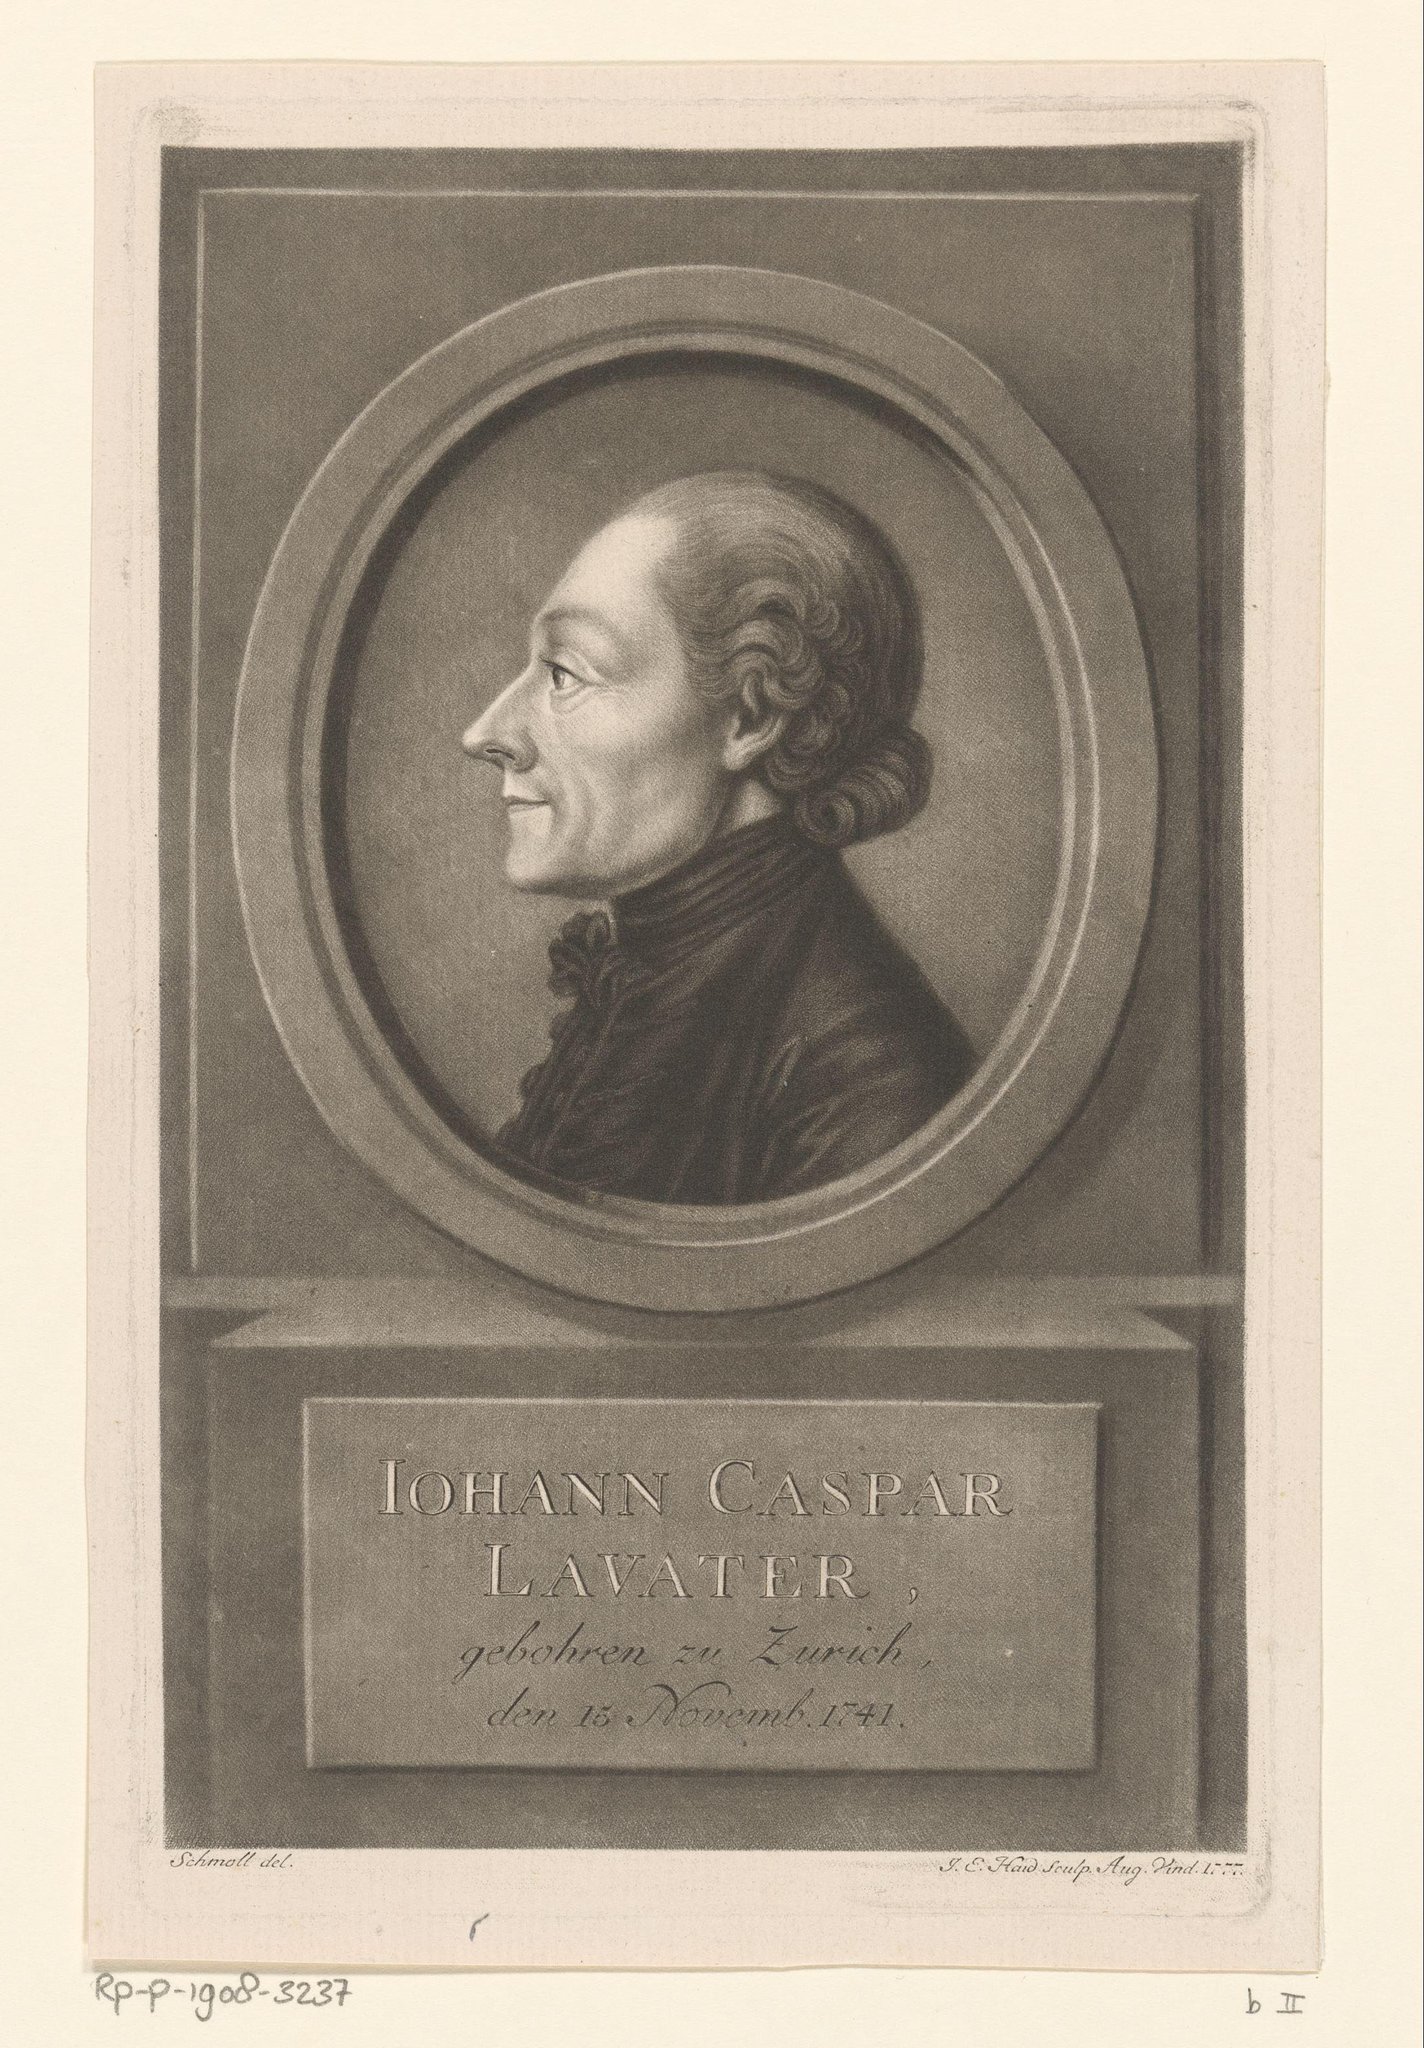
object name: print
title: Portret van Johann Caspar Lavater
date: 1777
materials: paper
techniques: mezzotint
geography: augsburg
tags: johann caspar lavater, historical persons, portrait of a writer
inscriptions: collector's mark: Lugt 2228